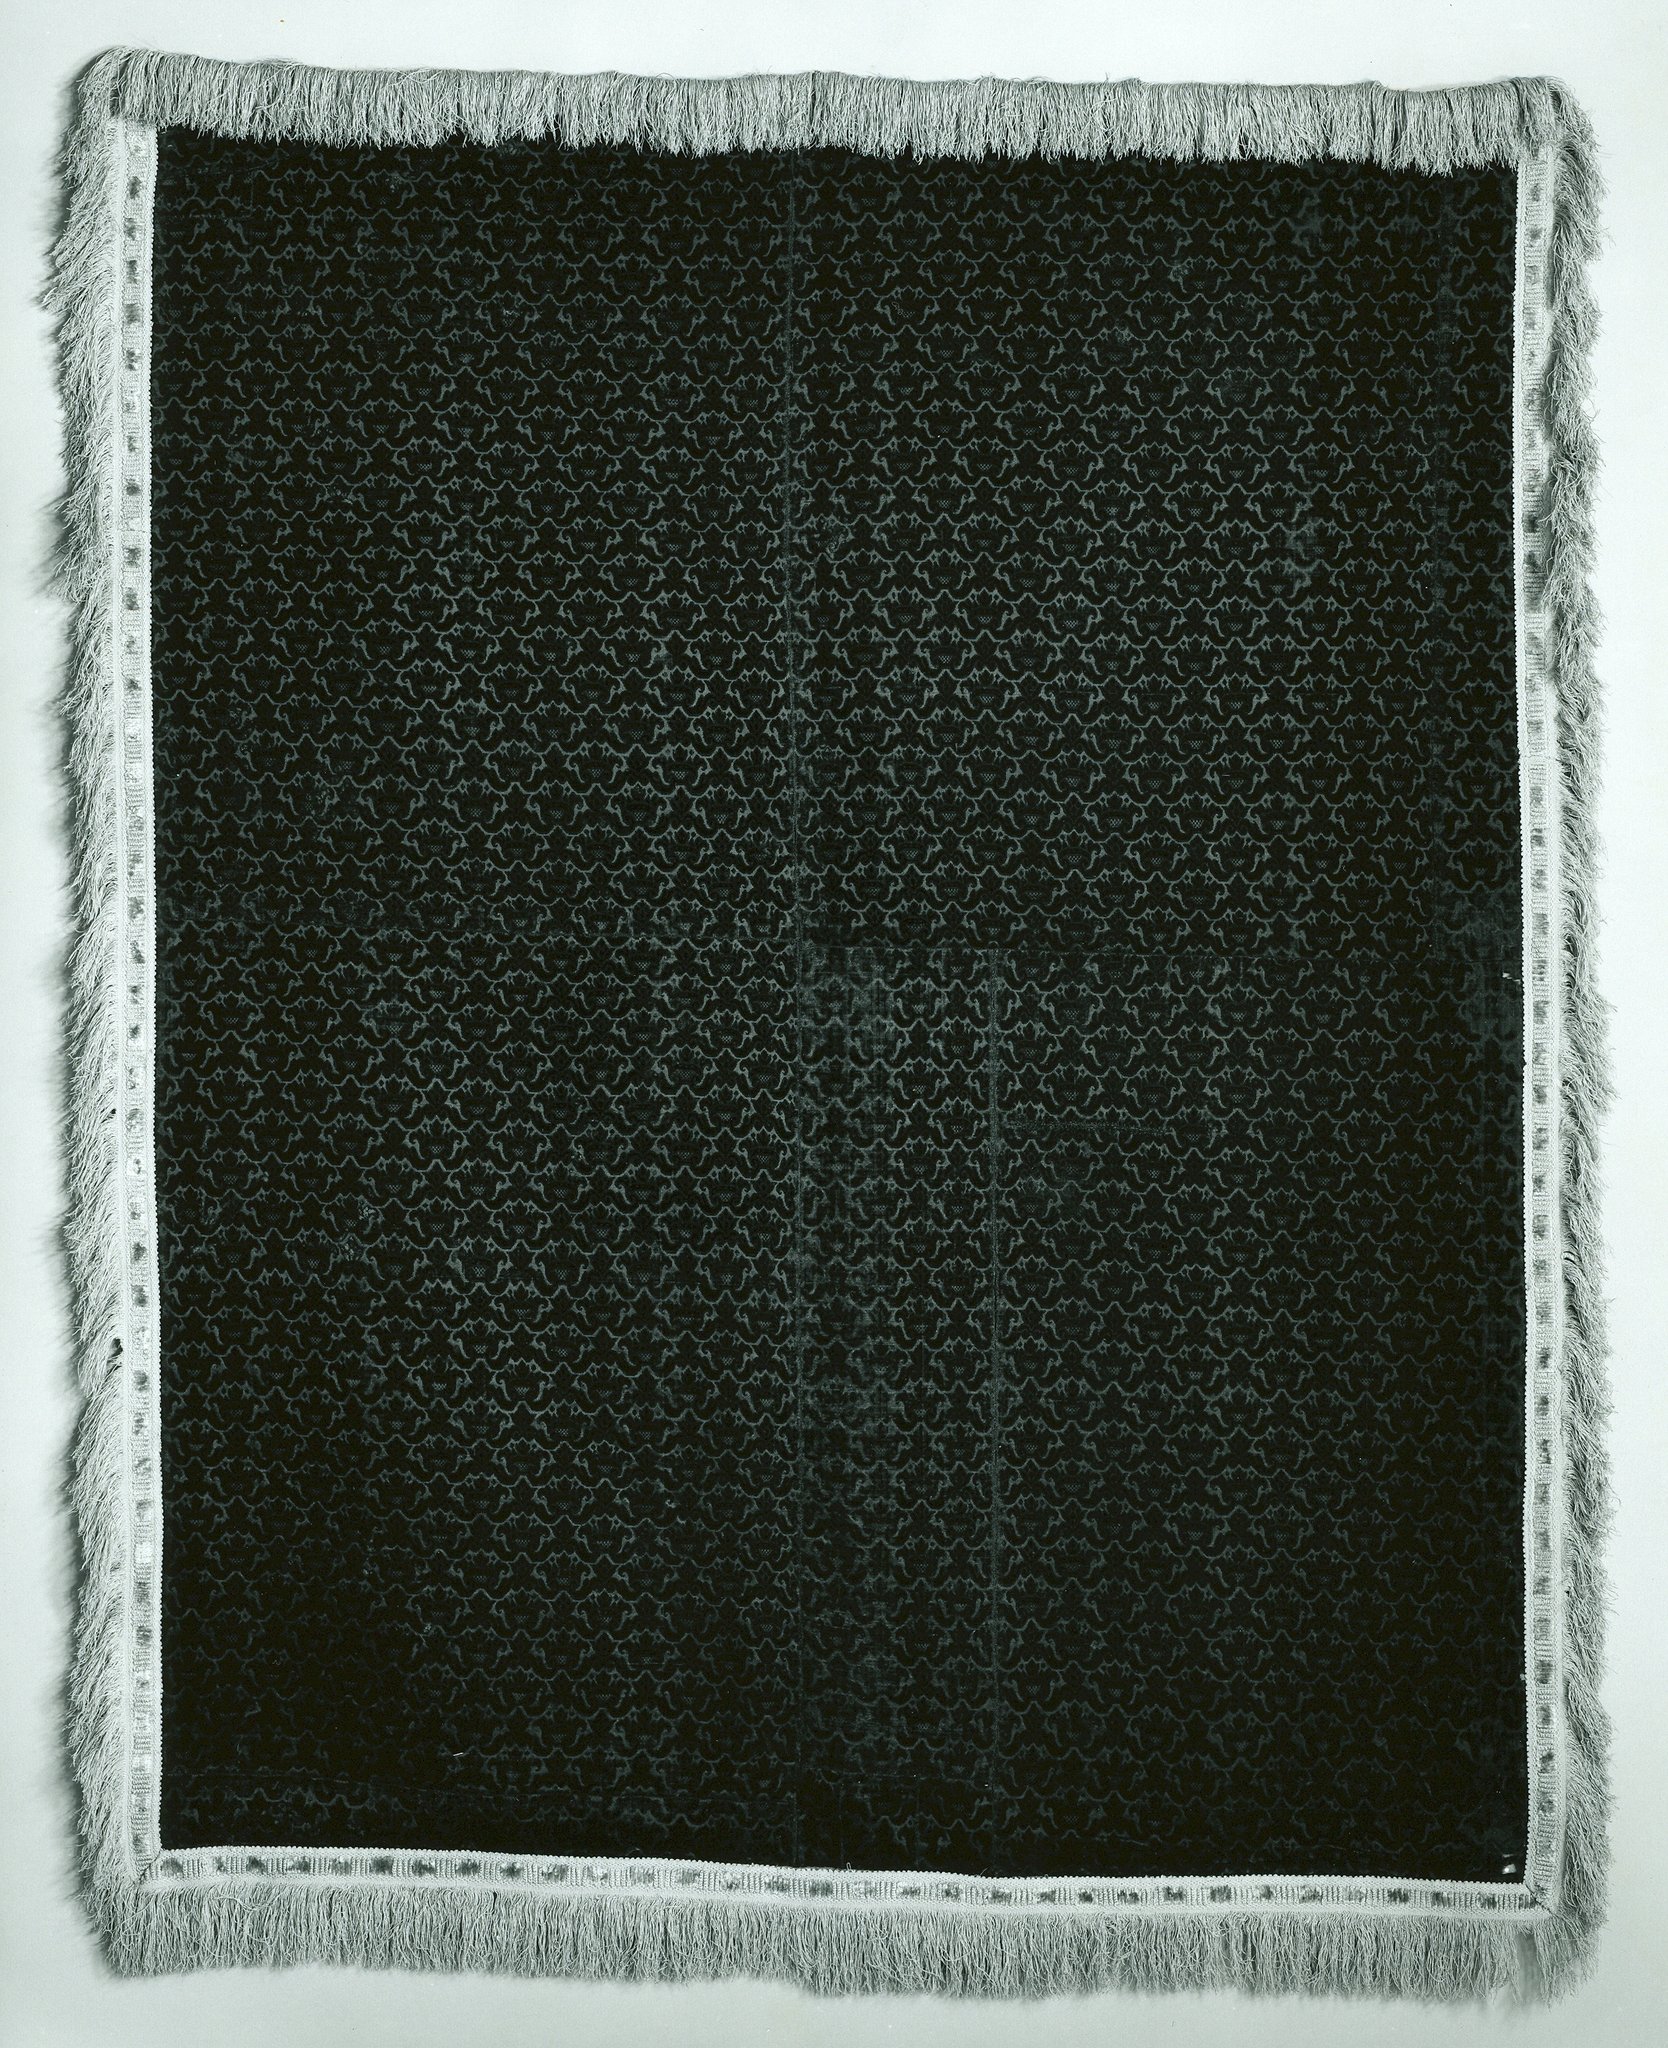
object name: textile cover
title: Cover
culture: italian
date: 1601-1633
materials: silk